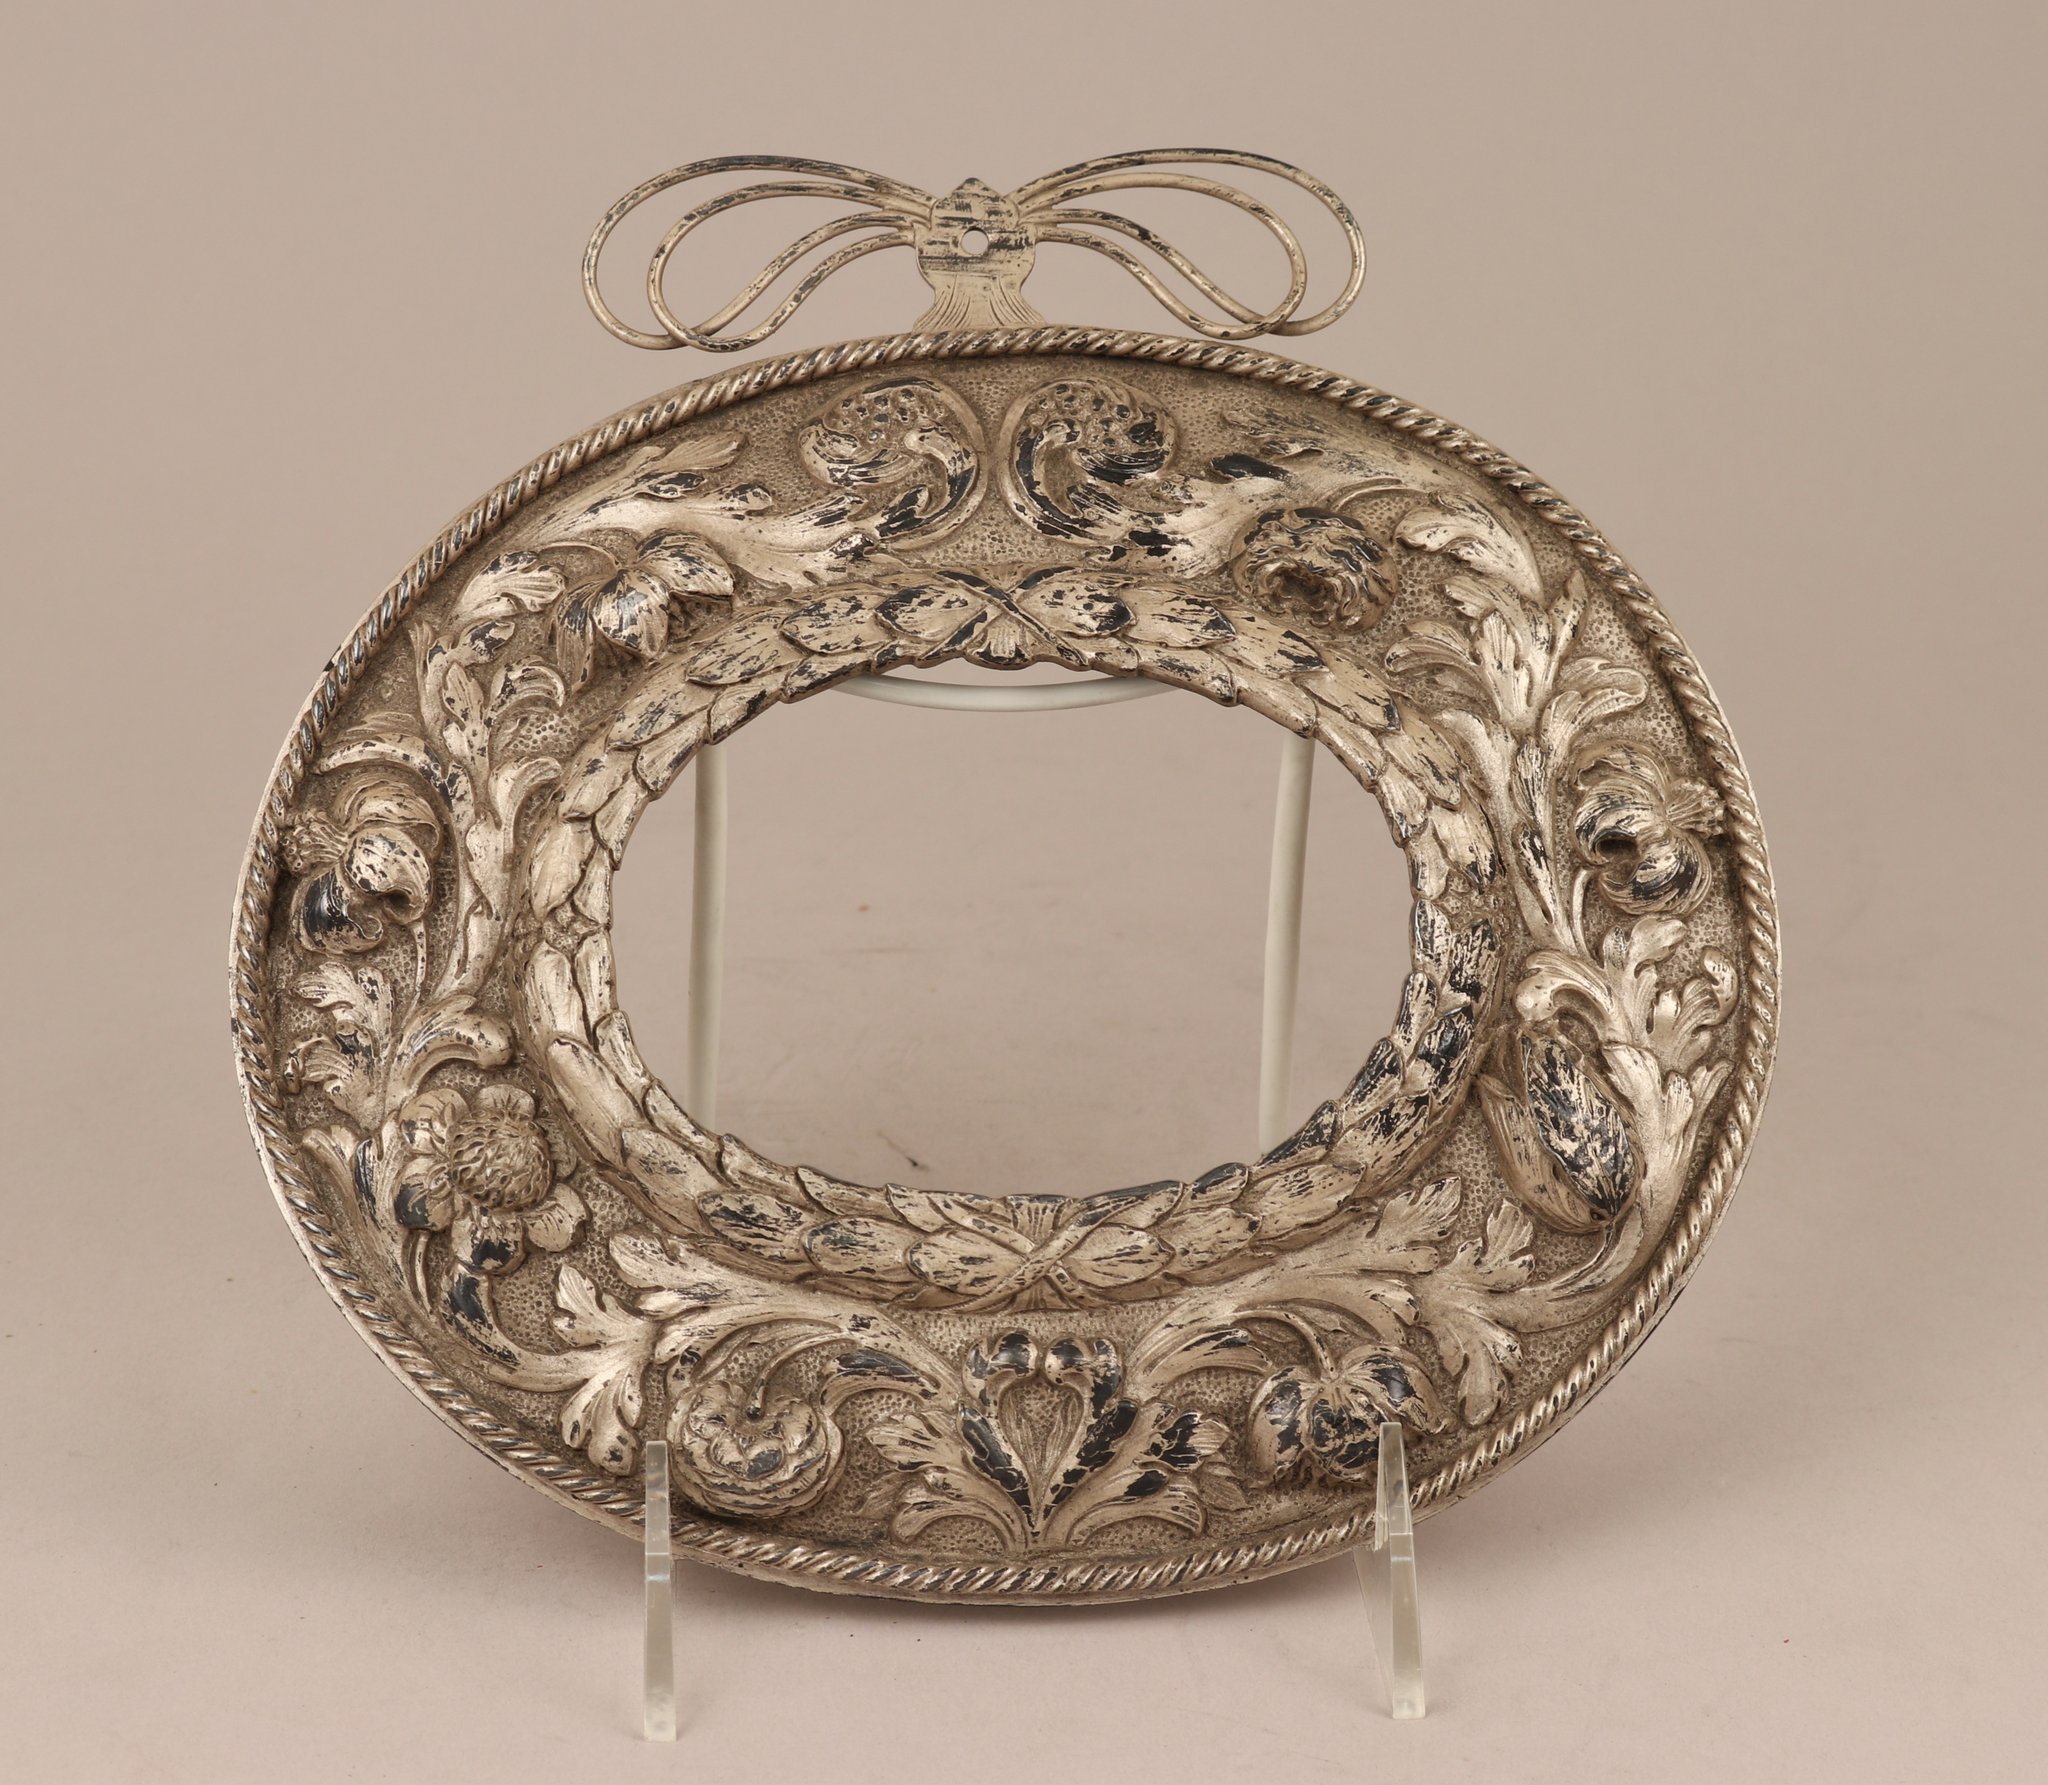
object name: picture frame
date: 1801-1900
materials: metal, silver